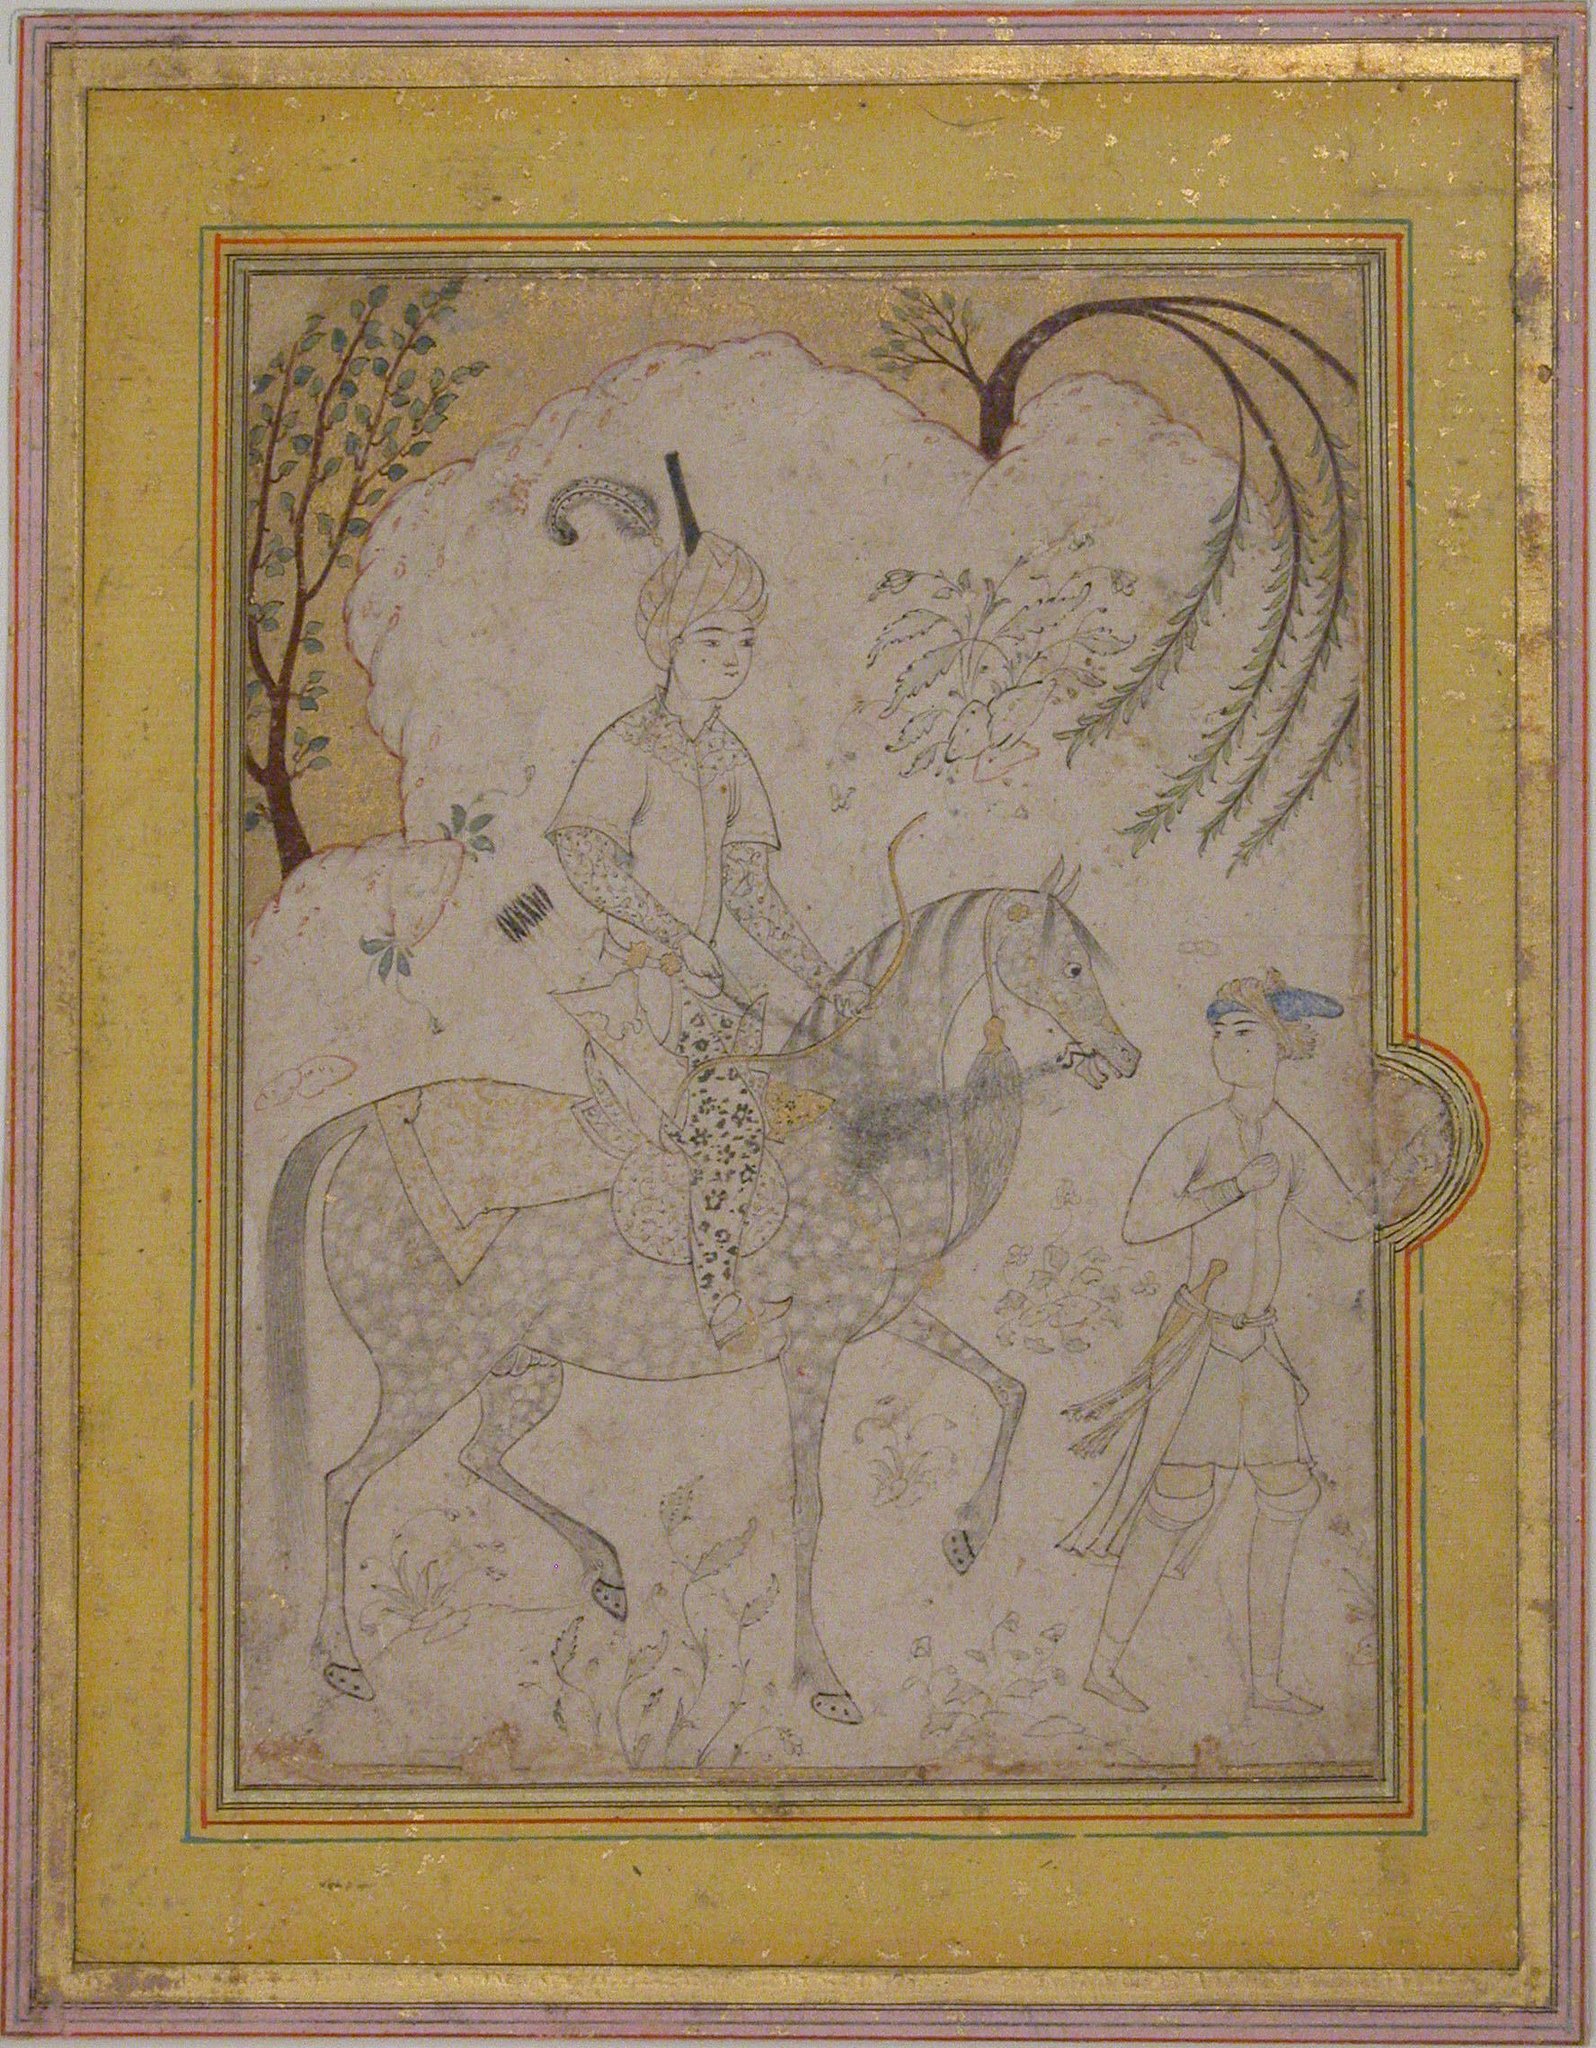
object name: illustrated single work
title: Prince and Groom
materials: gold, ink, paper, watercolor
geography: iran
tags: bow and arrow,princes,men,horses,trees